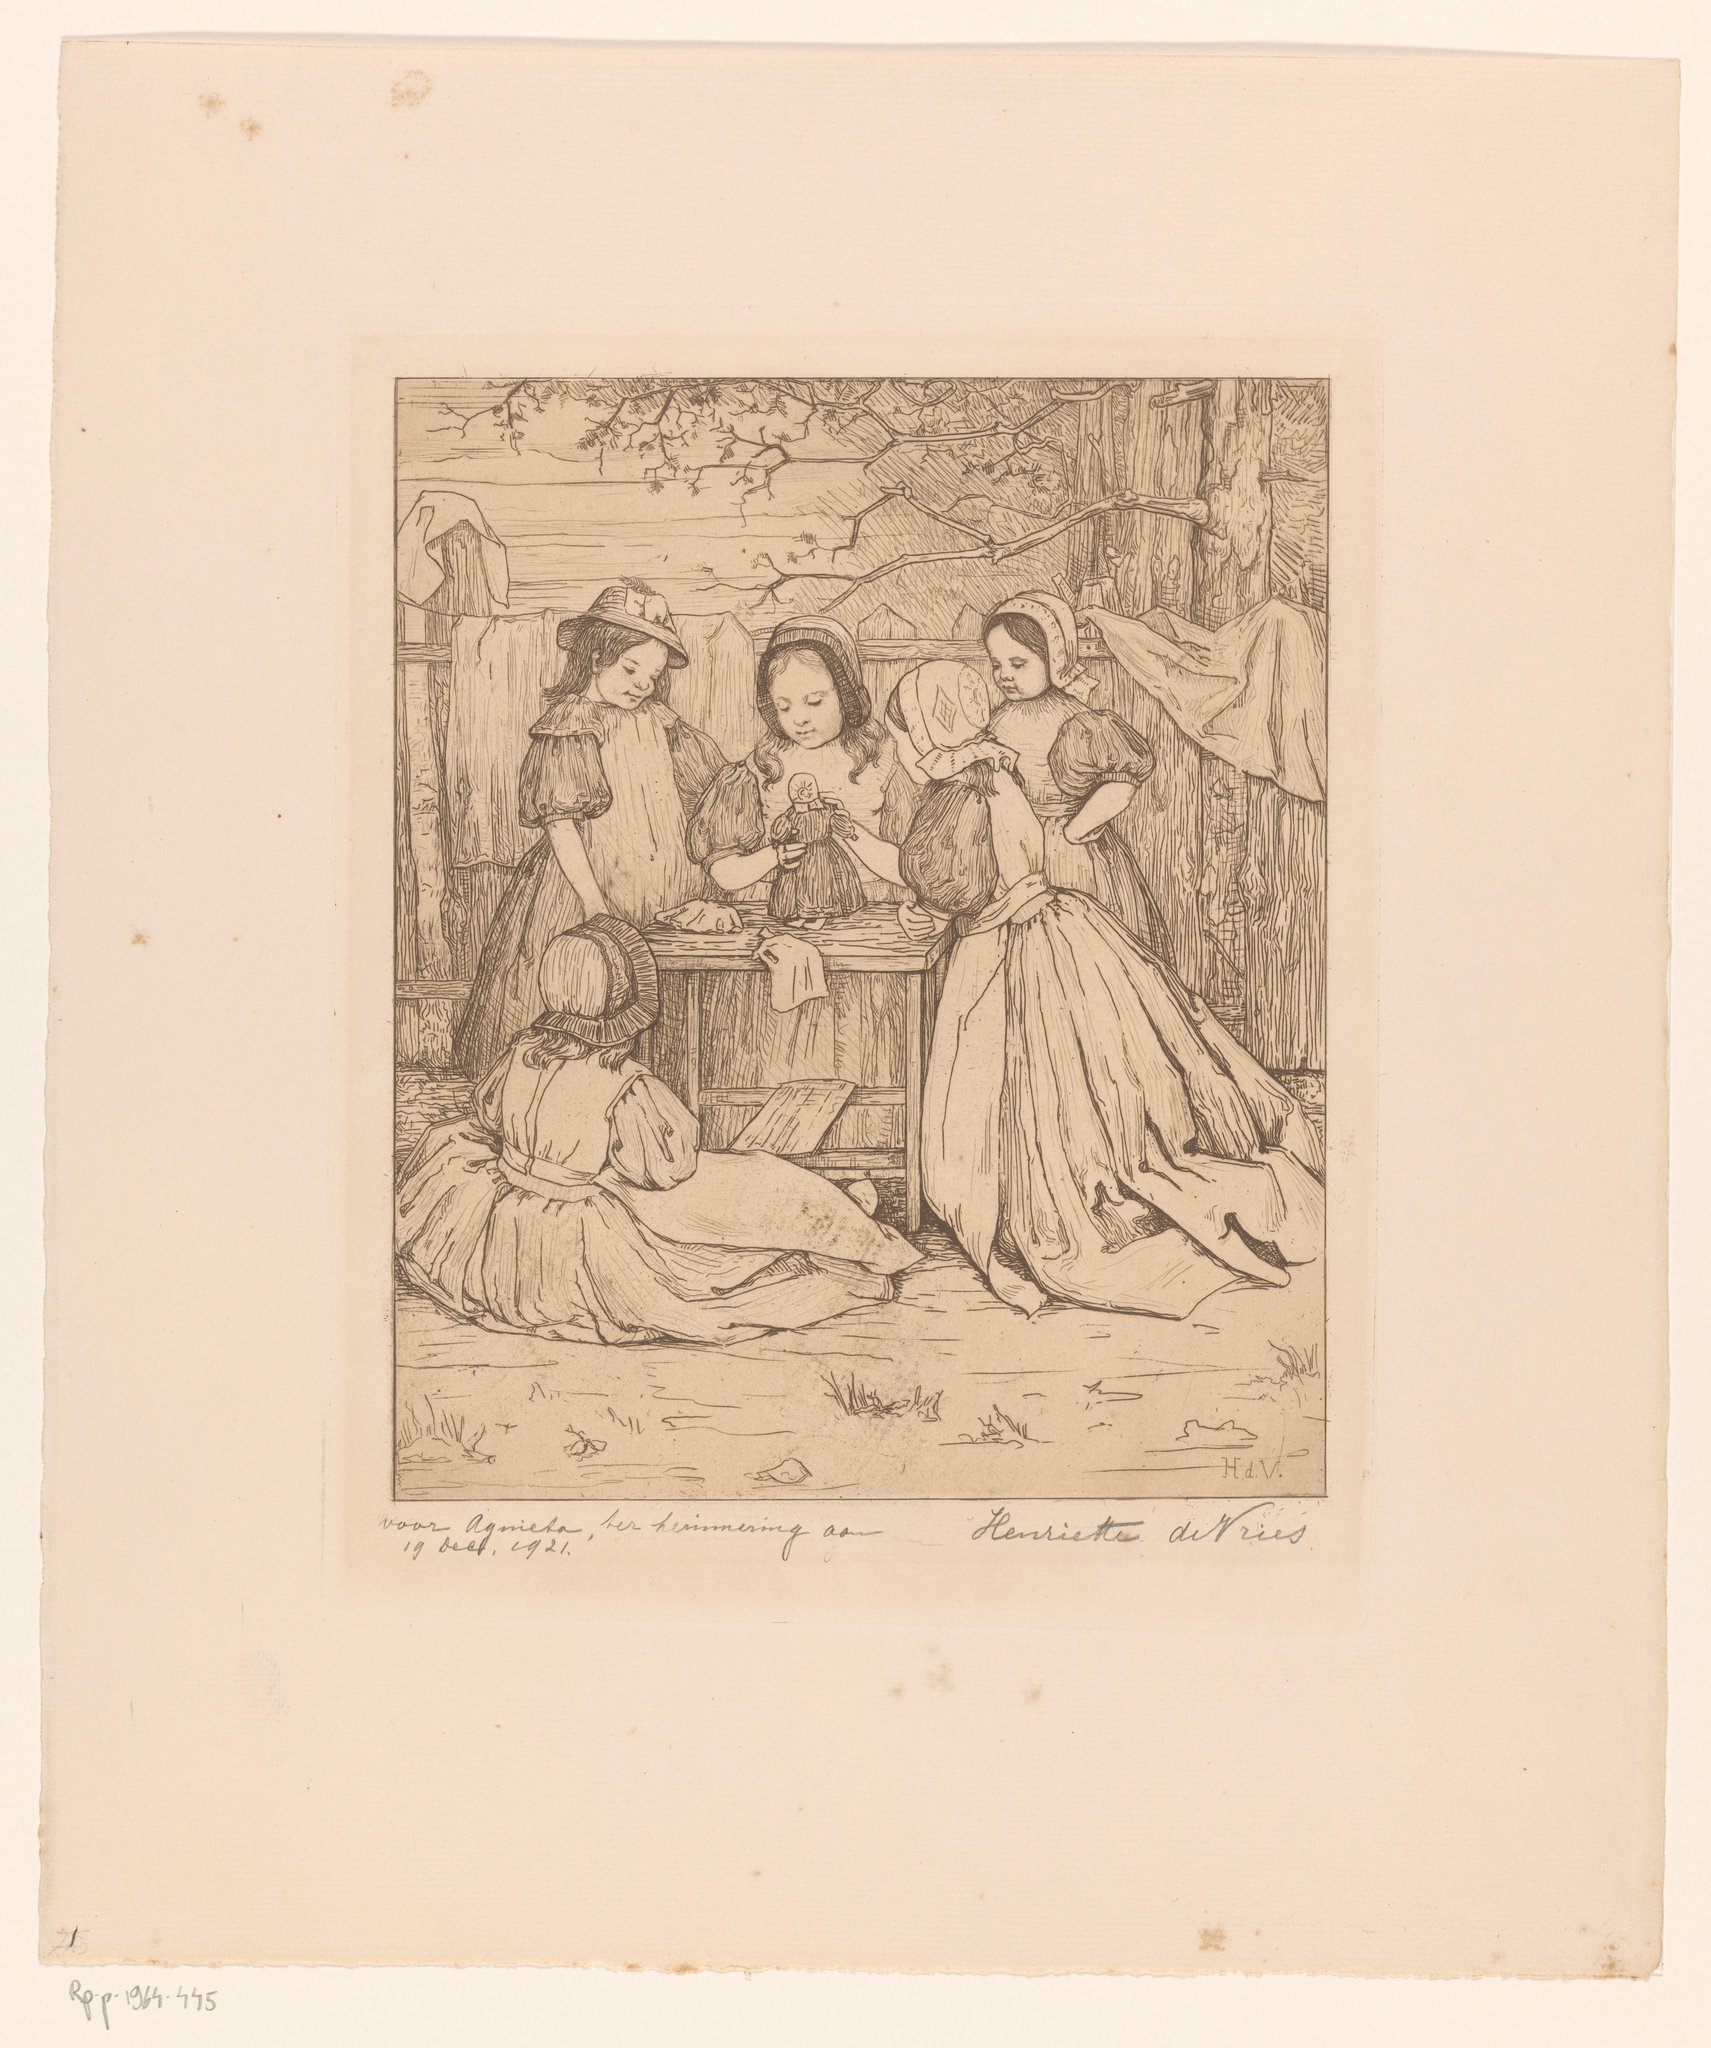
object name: print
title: Meisjes buiten spelend met een pop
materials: paper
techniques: drypoint, etching, intaglio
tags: girl (child between toddler and youth), (playing with) dolls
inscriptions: dedication: ‘voor Agnieta, ter herinnering aan/ 19 dec, 1921.’, collector's mark: Lugt 2228